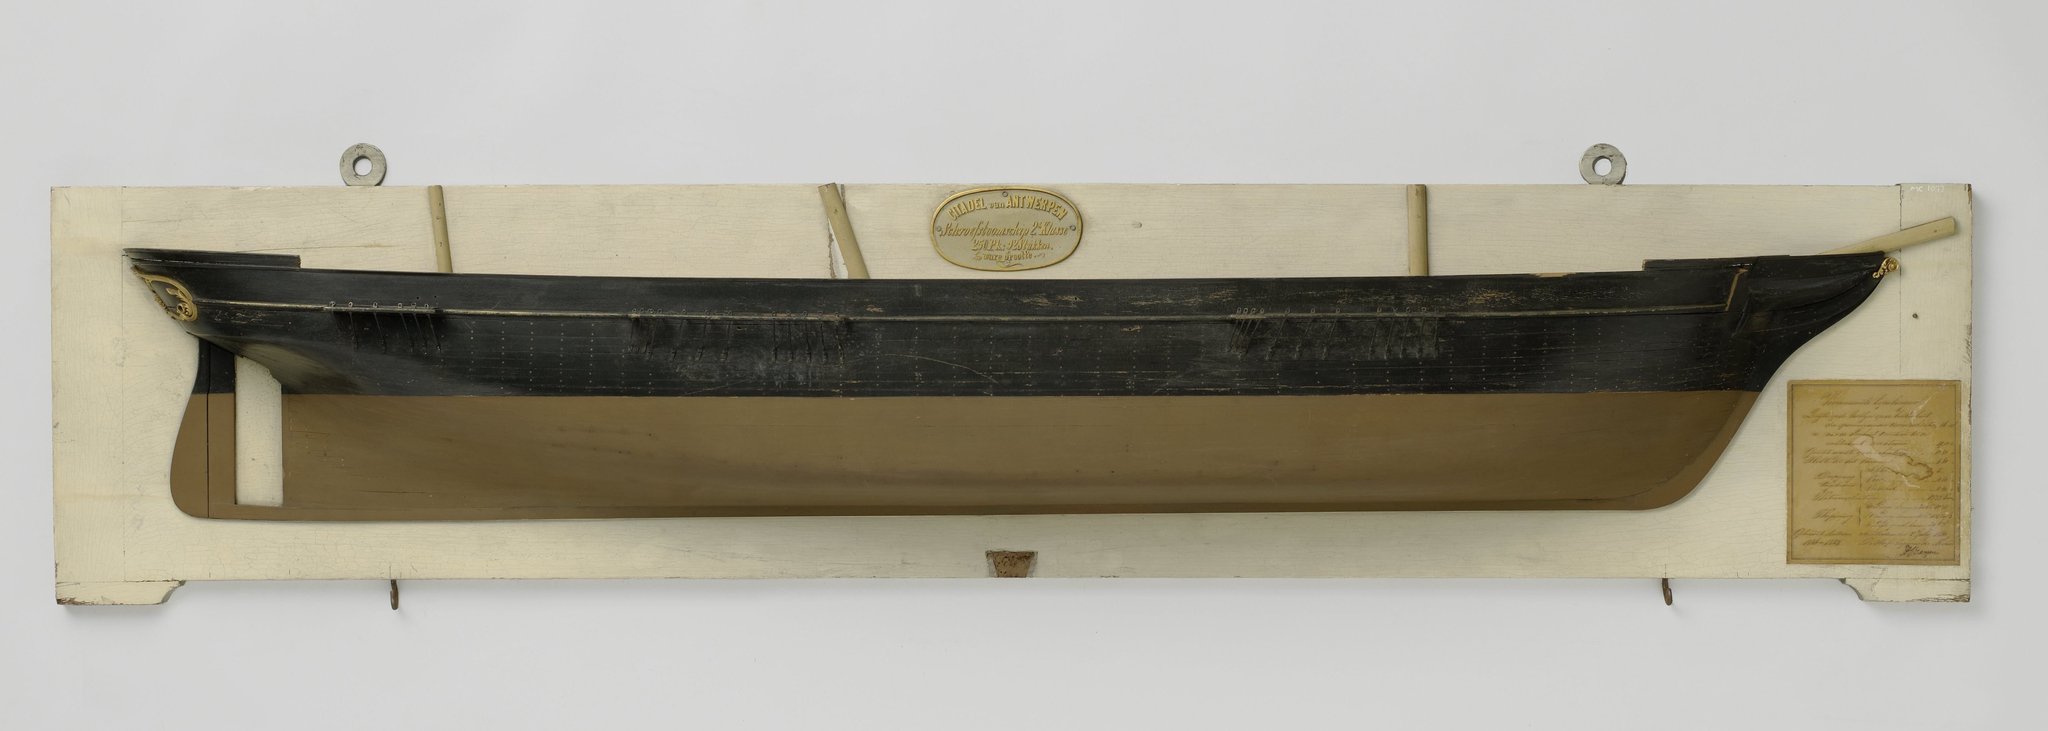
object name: half model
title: Half Model of a Screw Steamer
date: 1857-1860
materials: brass, wood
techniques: polychromy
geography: amsterdam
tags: dordrecht (schip), citadel van antwerpen (schip)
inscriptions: inscription, top centre, on an oval light blue label: ‘CITADEL van ANTWERPEN / Schroefstoomschip 2e Klasse / 250 Pk: 12 Stukken. / 1/50 ware grootte.’, inscription, bottom right, on a piece of paper, in ink: ‘Voornaamste bepalingen. / [followed by measurements and armament, ed.] / Amsterdam 2 Juli 1860 / De Hoofd Ingenieur der Marine / H.G. Jansen. / [followed by scale, ed.]’